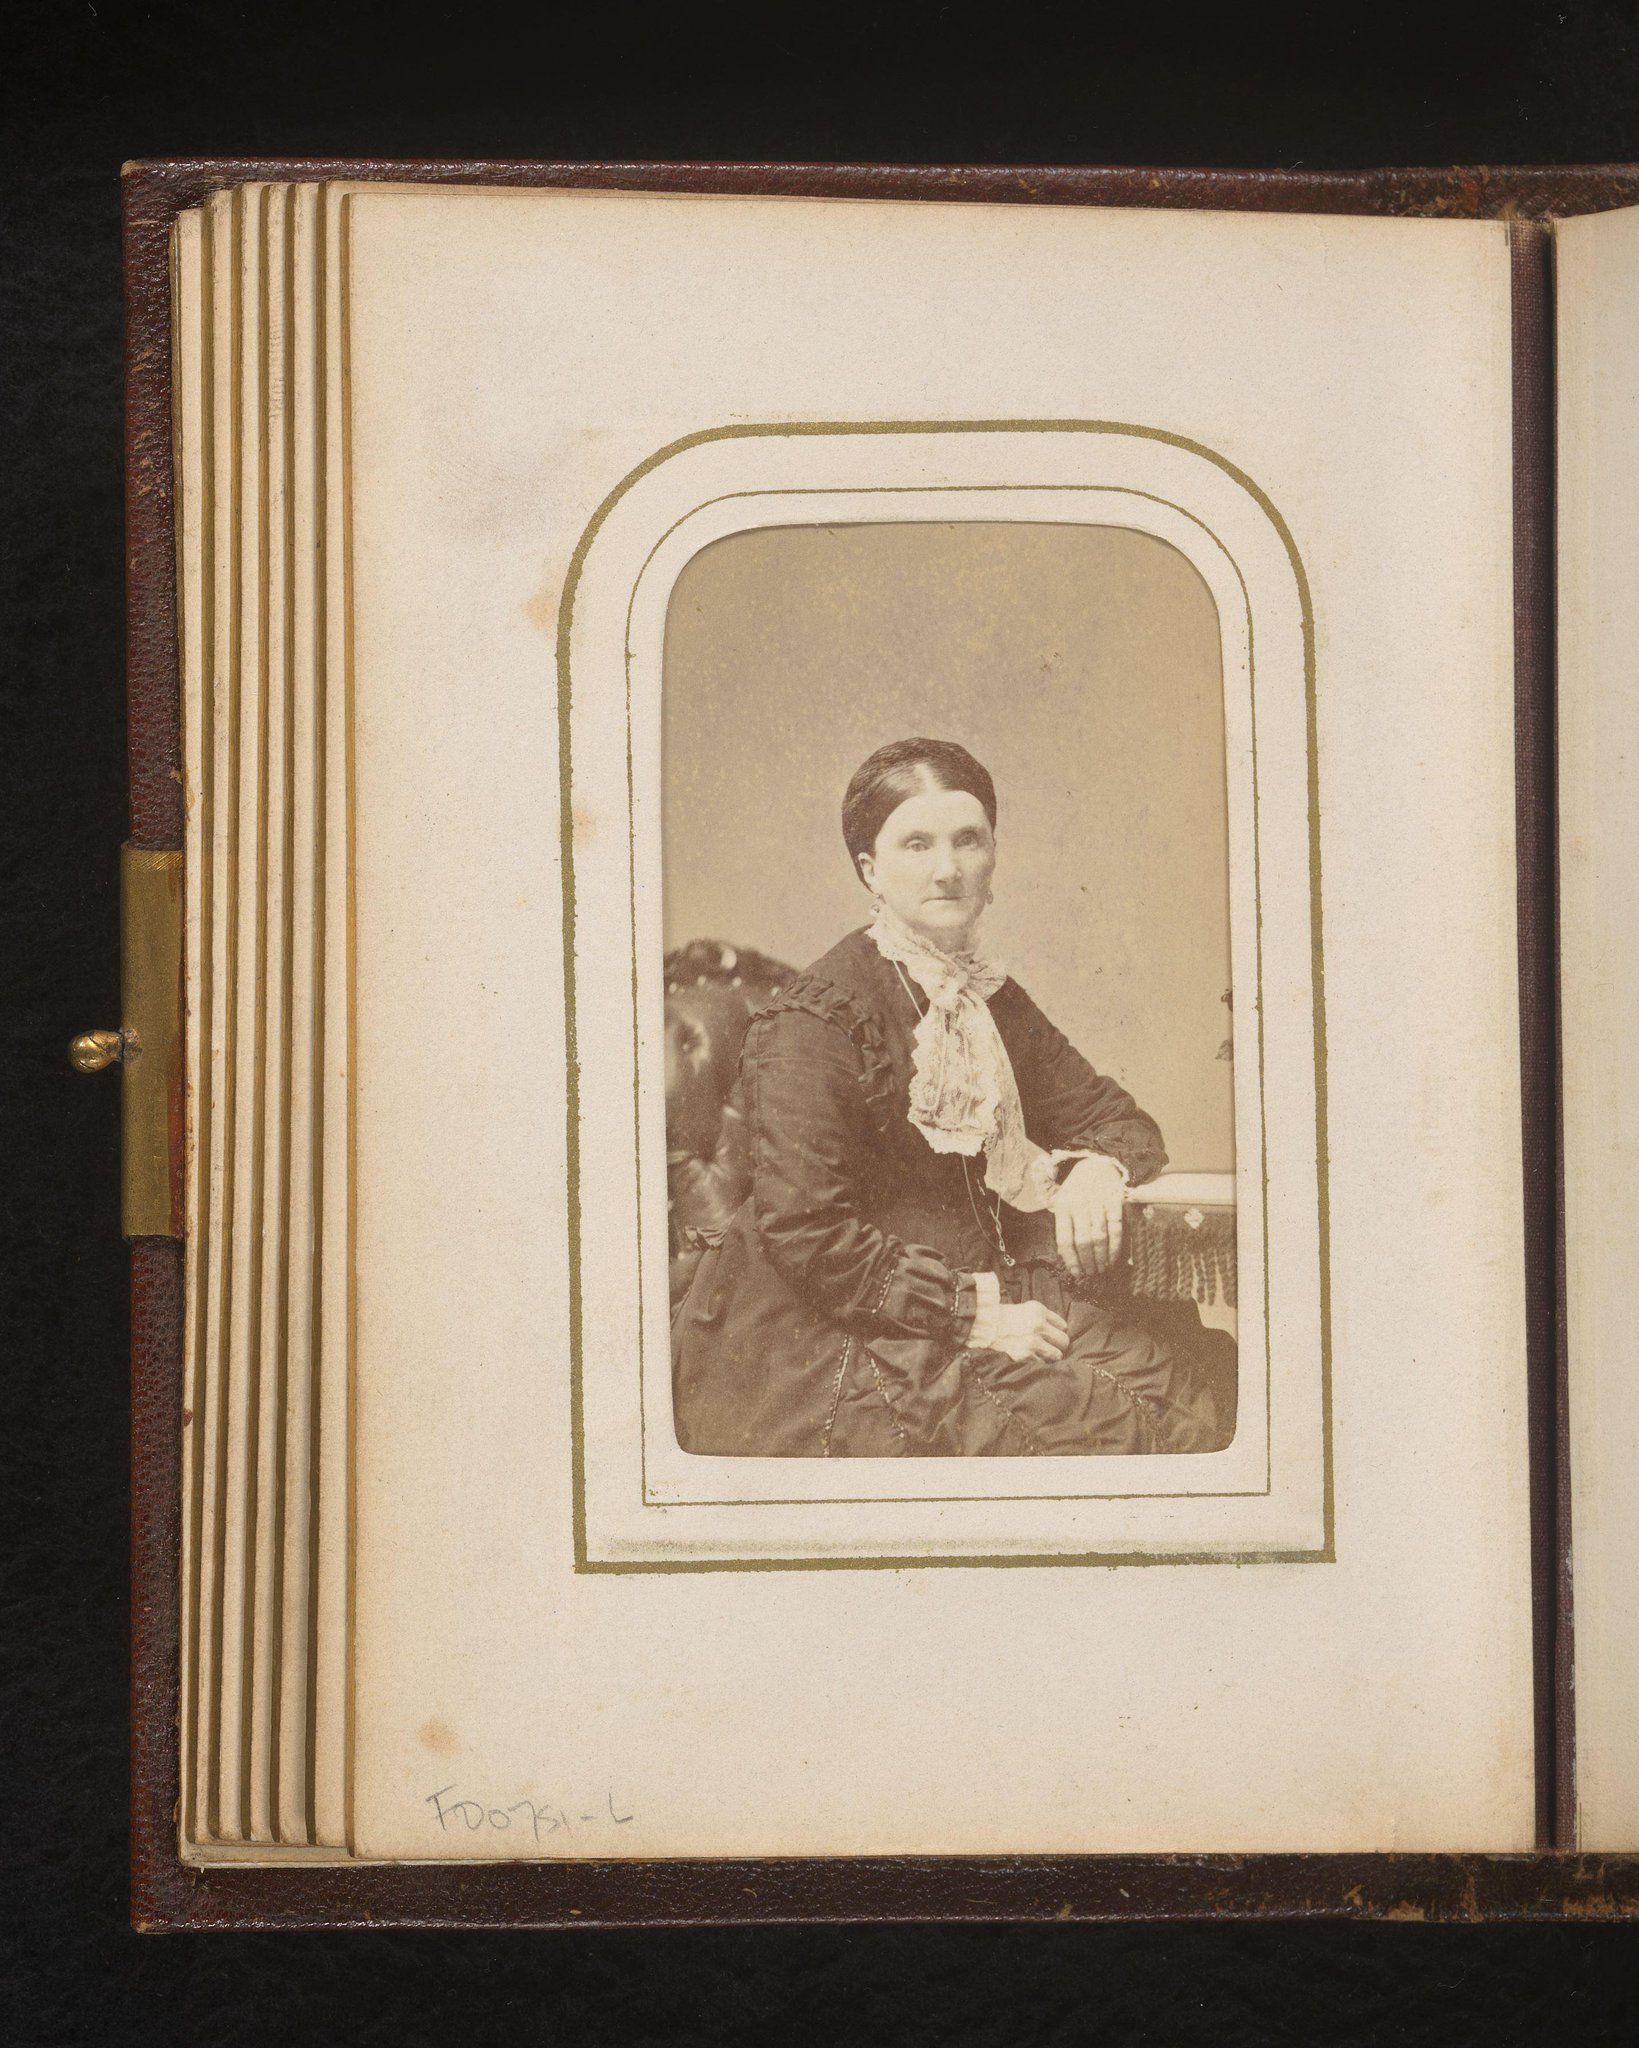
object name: carte de visite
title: Portret van een zittende vrouw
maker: r. tudor williams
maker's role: fotograaf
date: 1860-1900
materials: cardboard, photographic support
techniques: albumen print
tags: sitting figure, adult woman, historical persons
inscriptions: inscription: ‘RTW/ R. Tudor Williams/ Photographer/ Monow Street/ Mommouth’